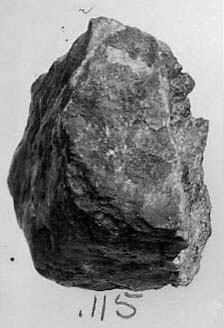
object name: fragment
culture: russian, siberia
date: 1902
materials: jade